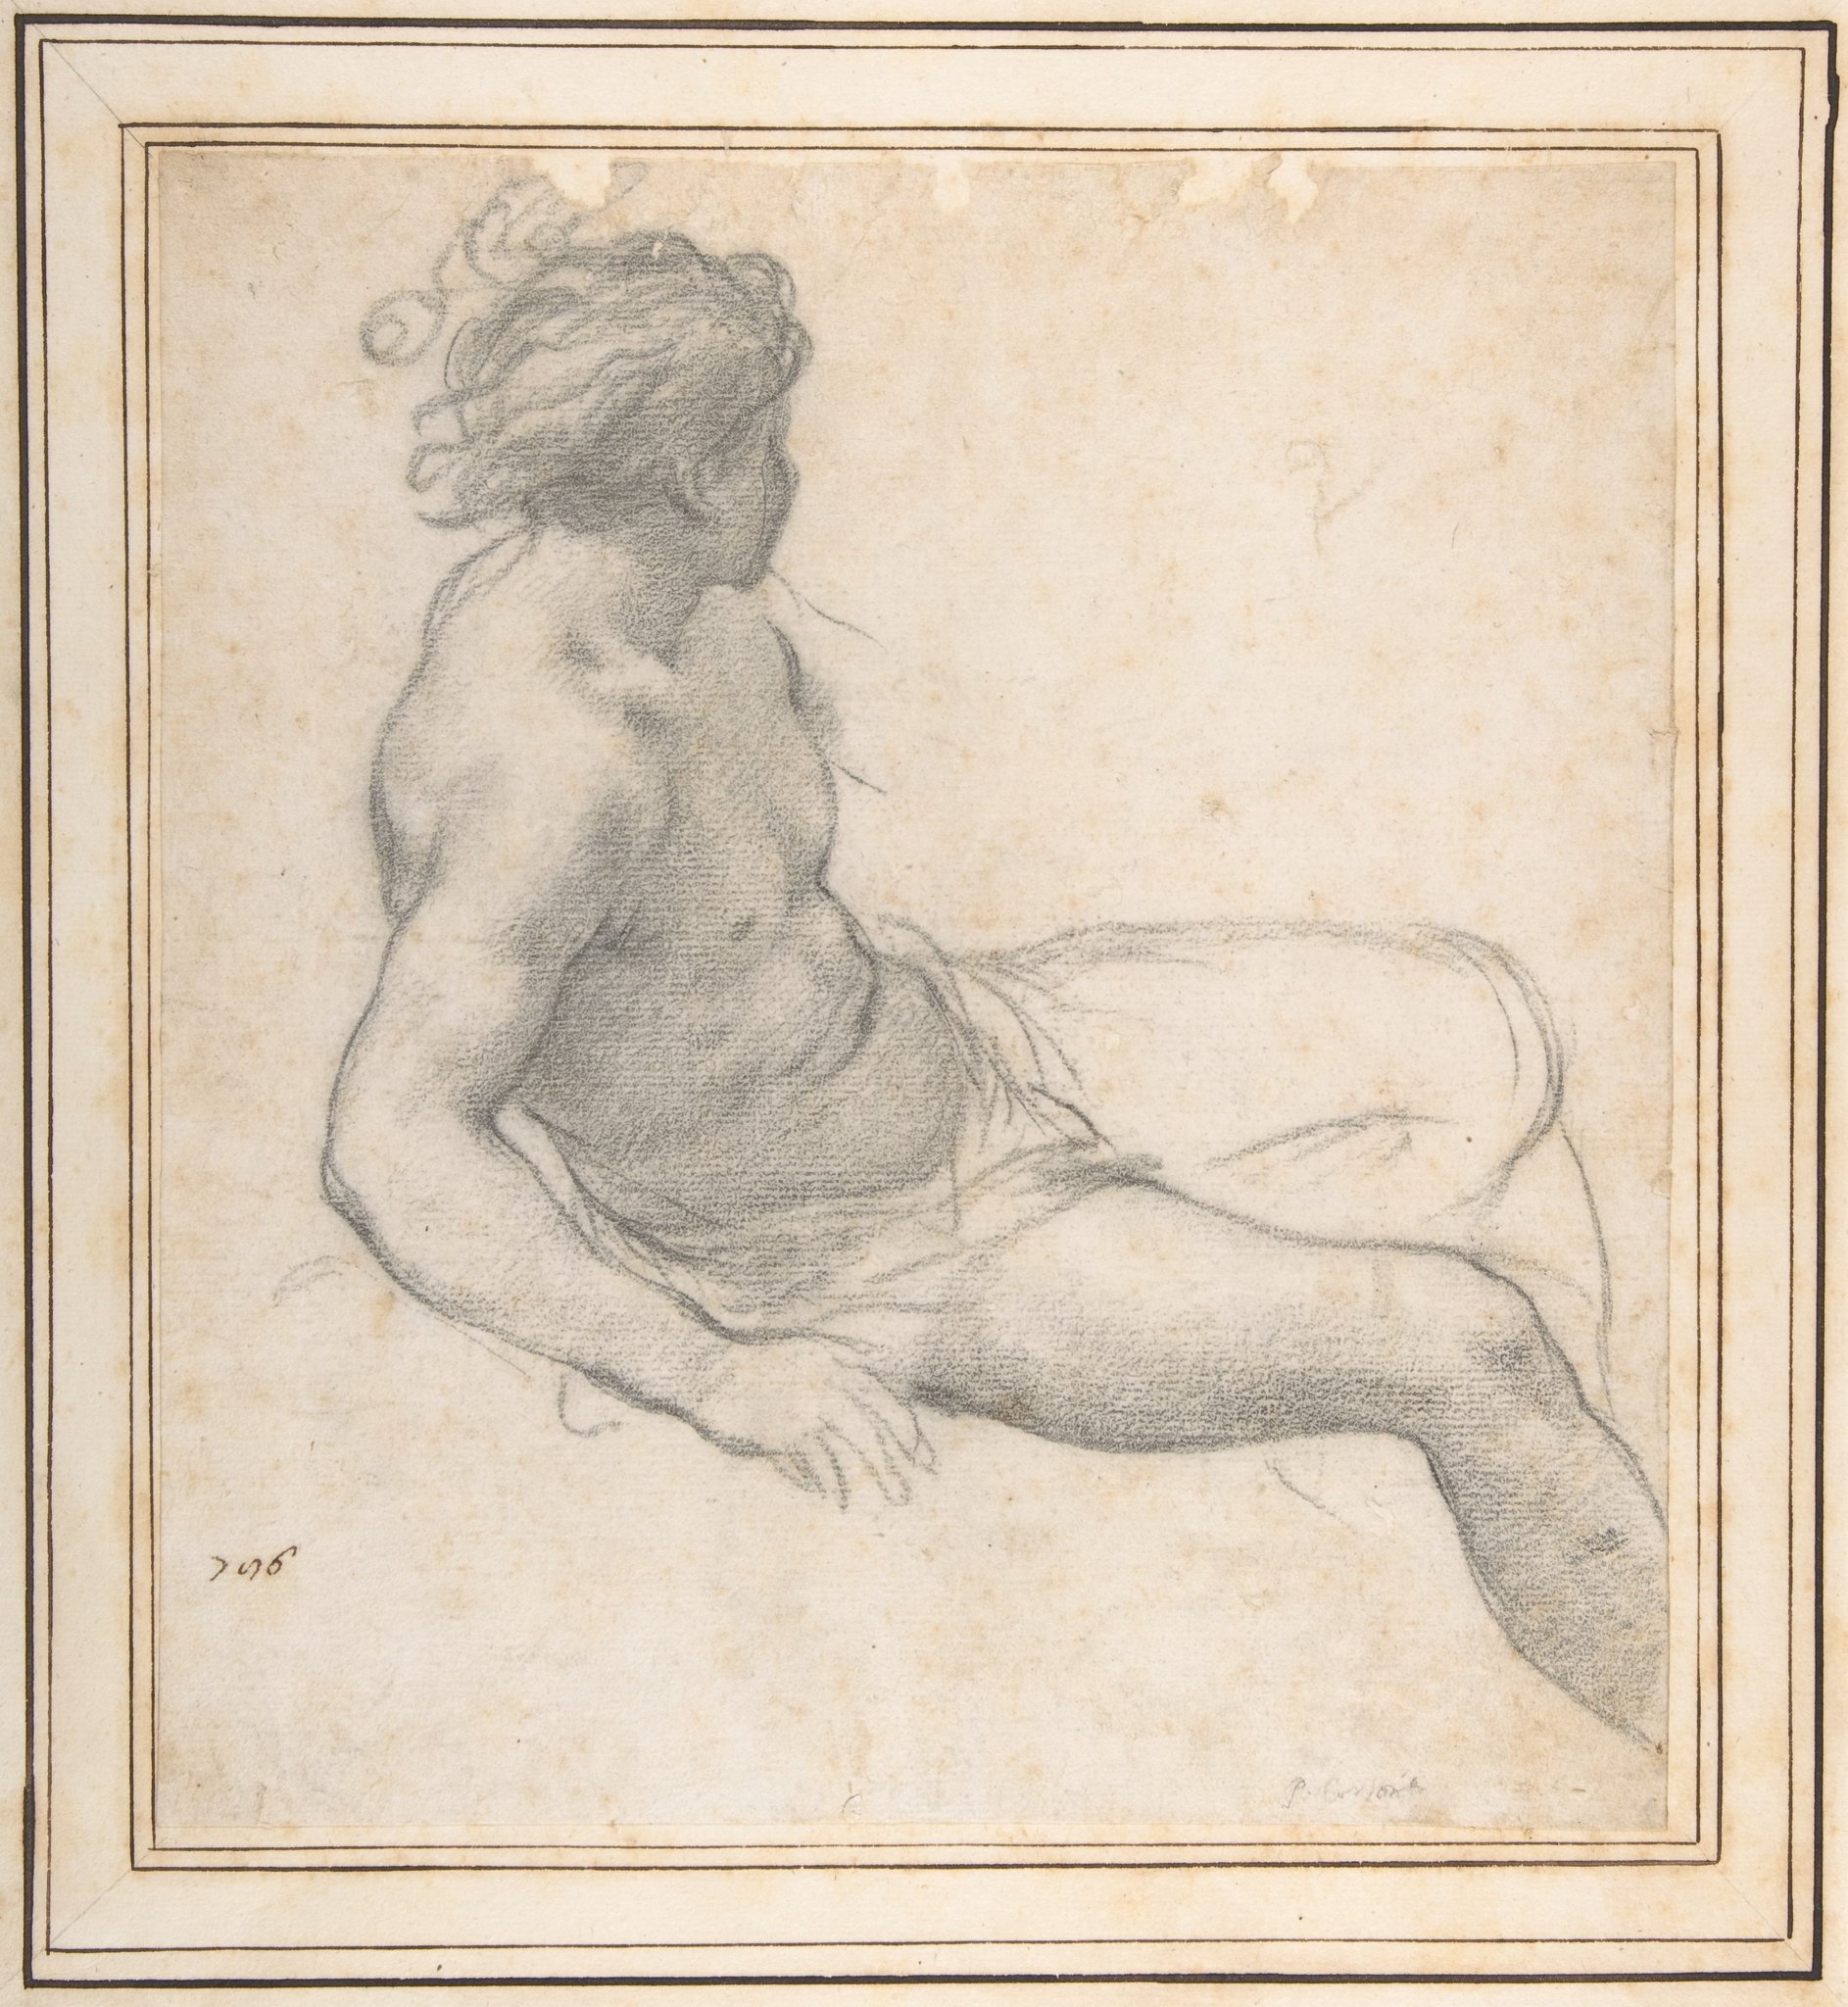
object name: drawing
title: Study of a Seated Youth for the Age of Gold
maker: pietro da cortona (pietro berrettini)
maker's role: artist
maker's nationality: italian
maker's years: 1596-1669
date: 1637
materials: chalk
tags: men